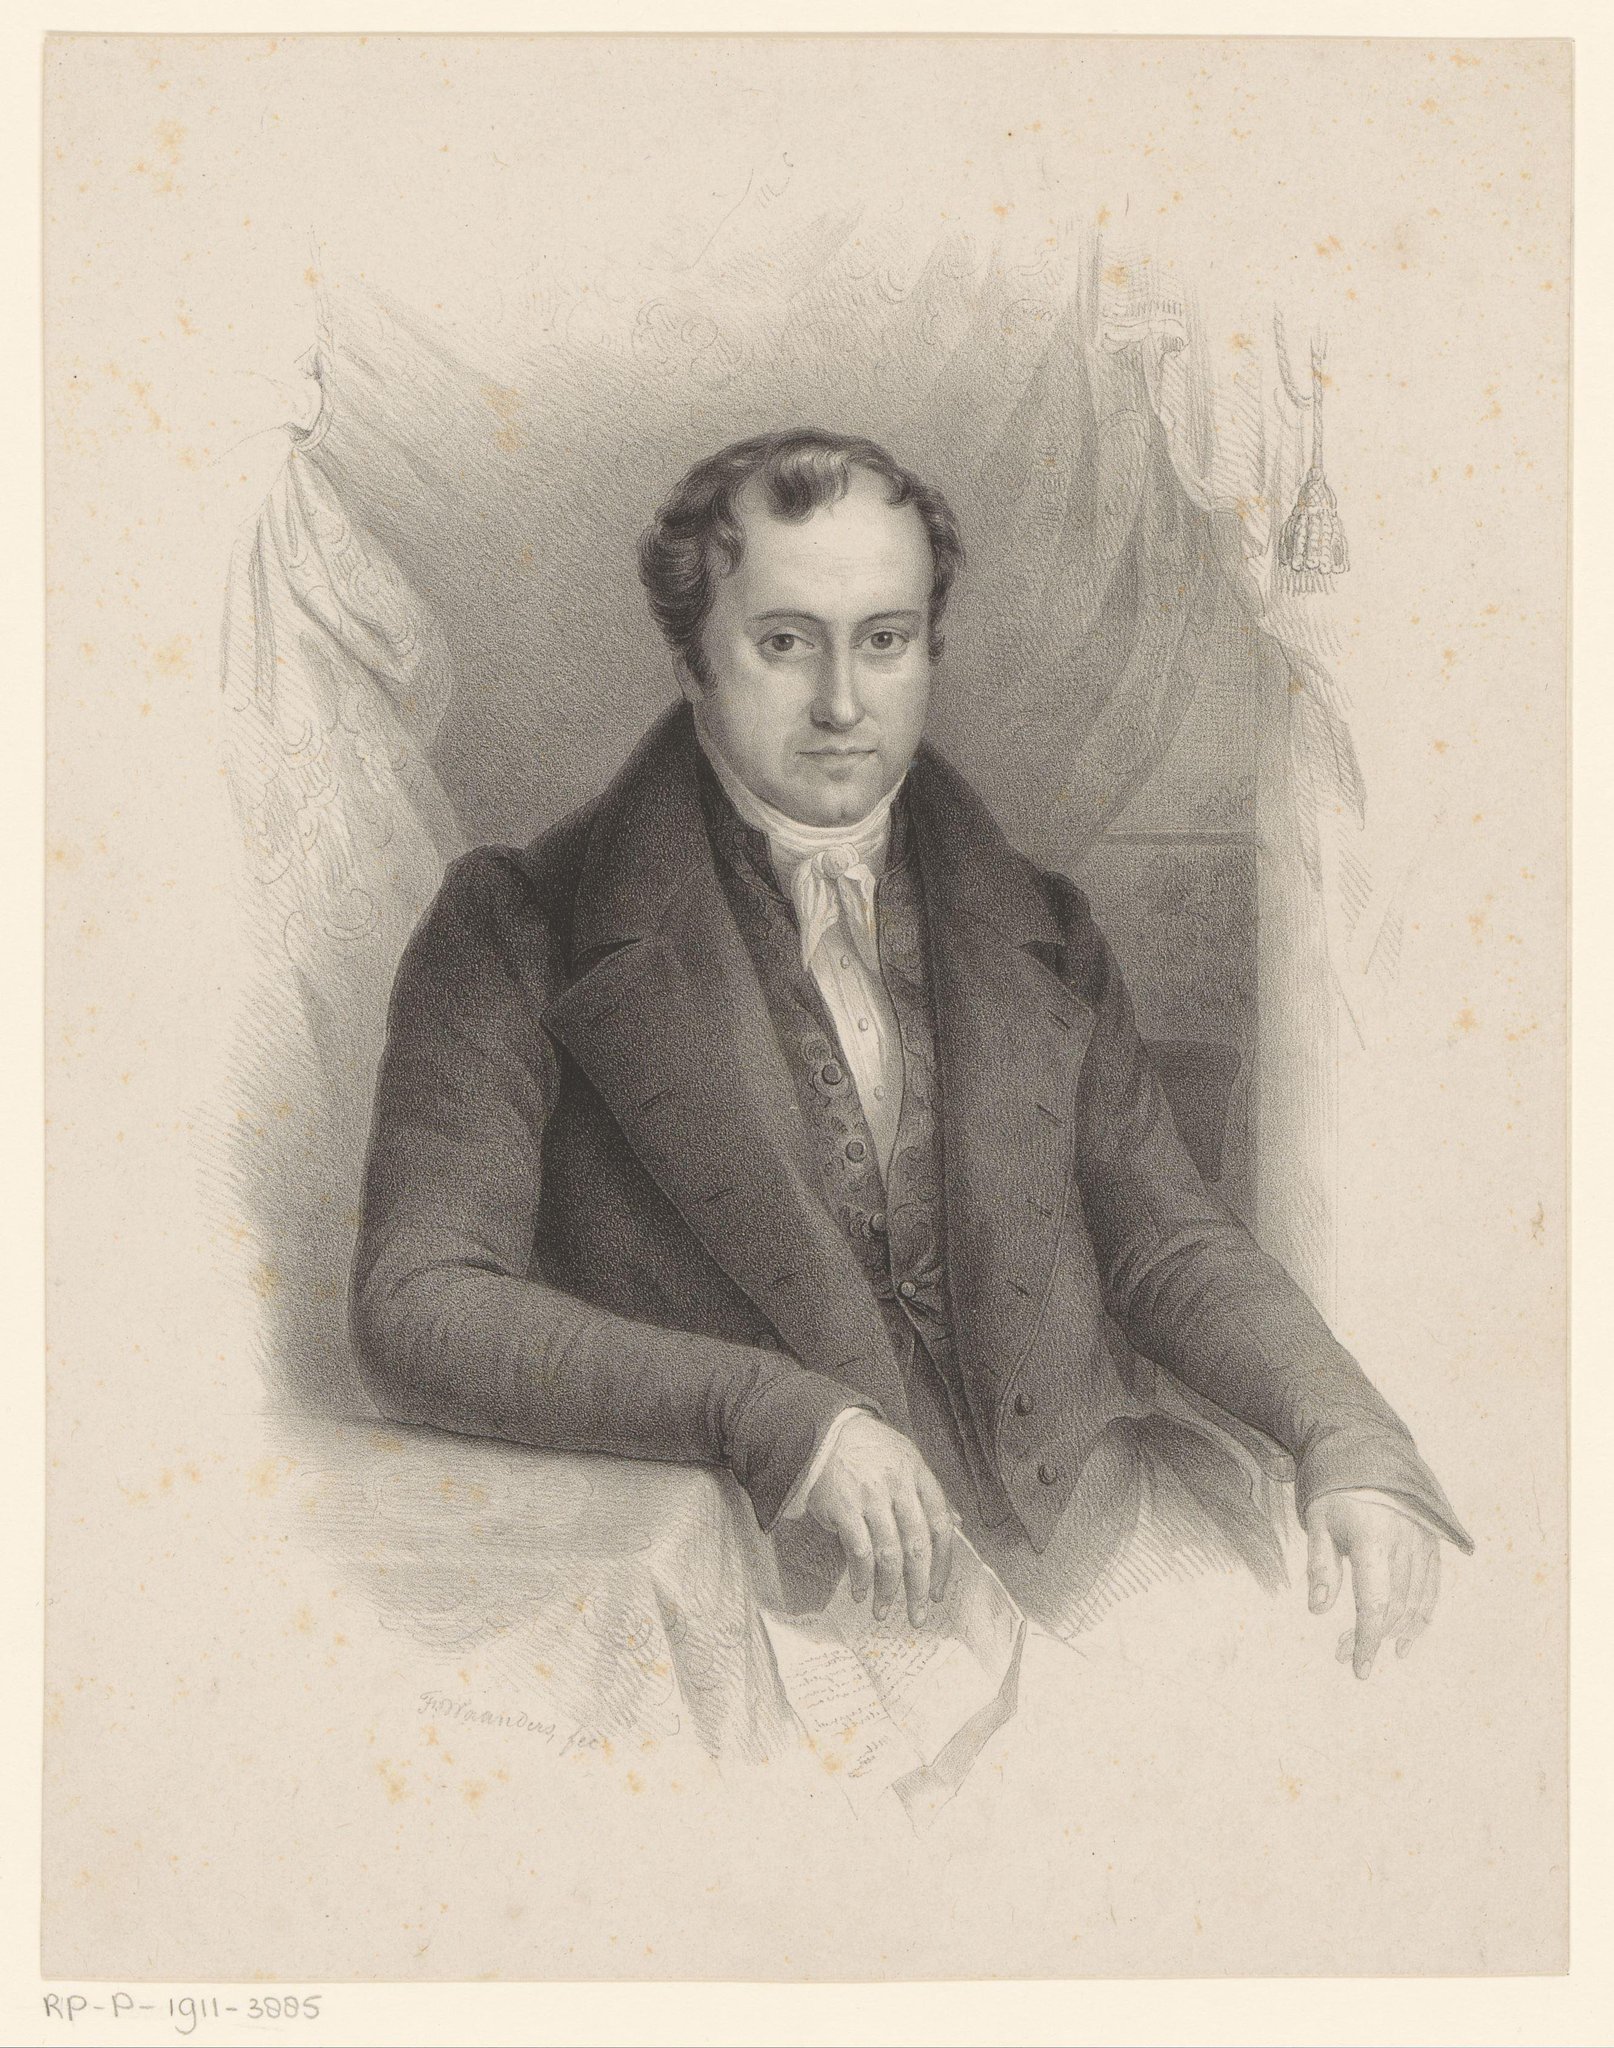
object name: print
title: Portret van de heer Van der Hoeven Jaarsveld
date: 1819-1880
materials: paper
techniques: lithograph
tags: historical persons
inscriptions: collector's mark: Lugt 2228